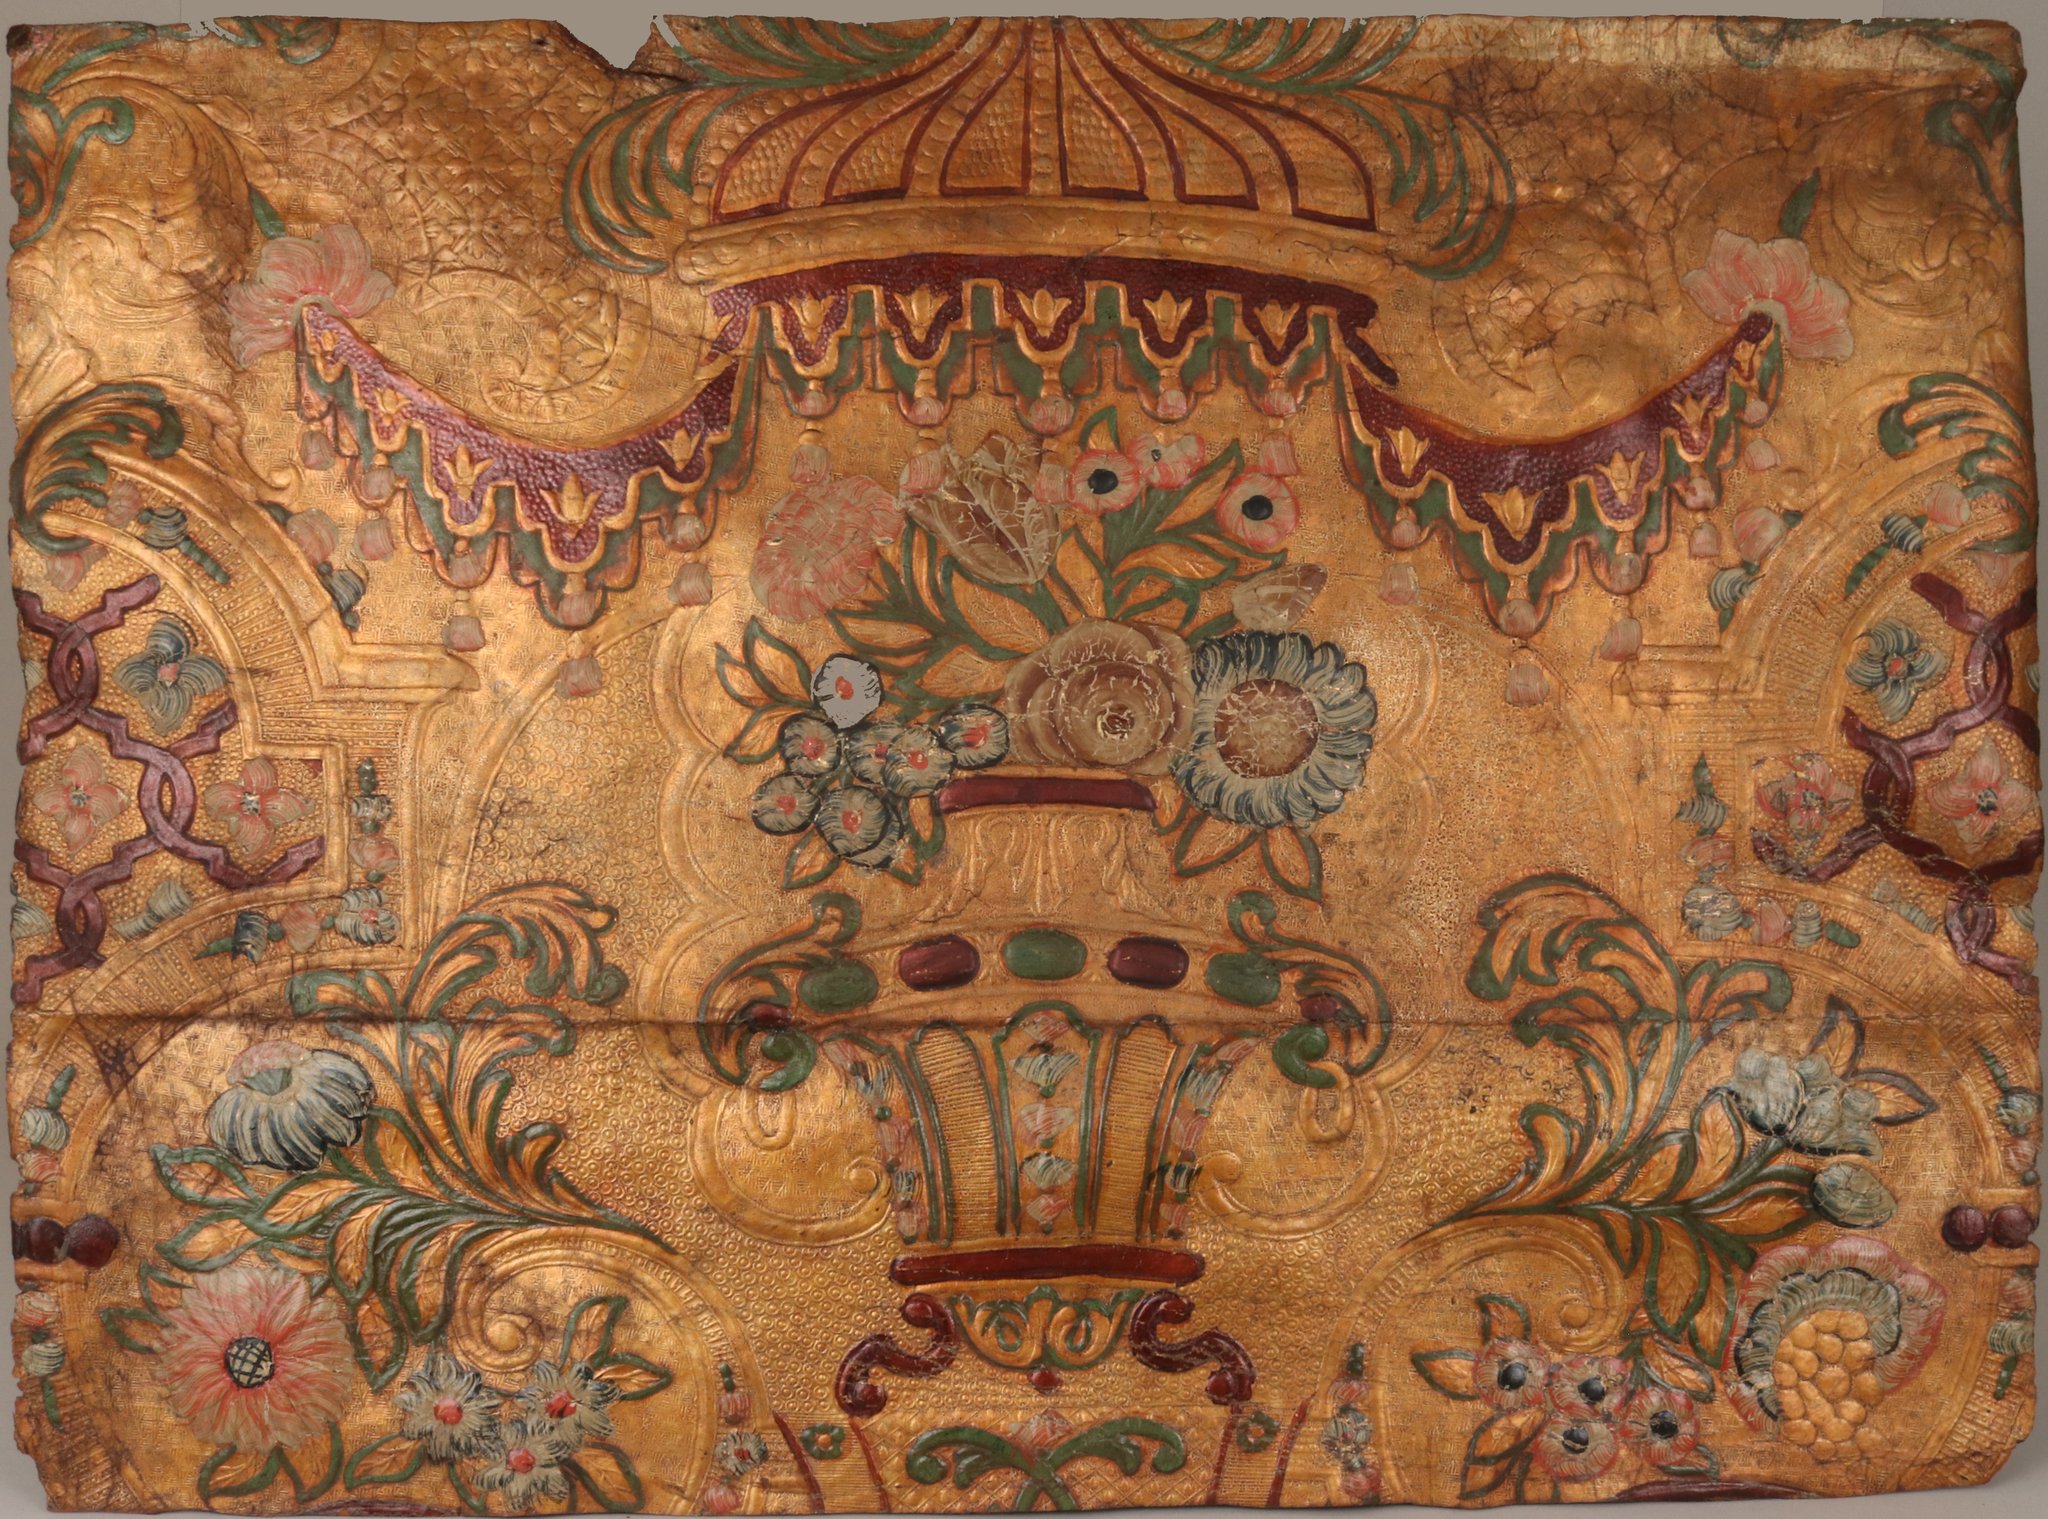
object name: wall hanging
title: Wall hanging fragment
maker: daniel marot the elder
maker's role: artist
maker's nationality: french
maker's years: 1661-1752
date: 1701-1725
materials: leather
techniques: embossing, gilding, polychrome